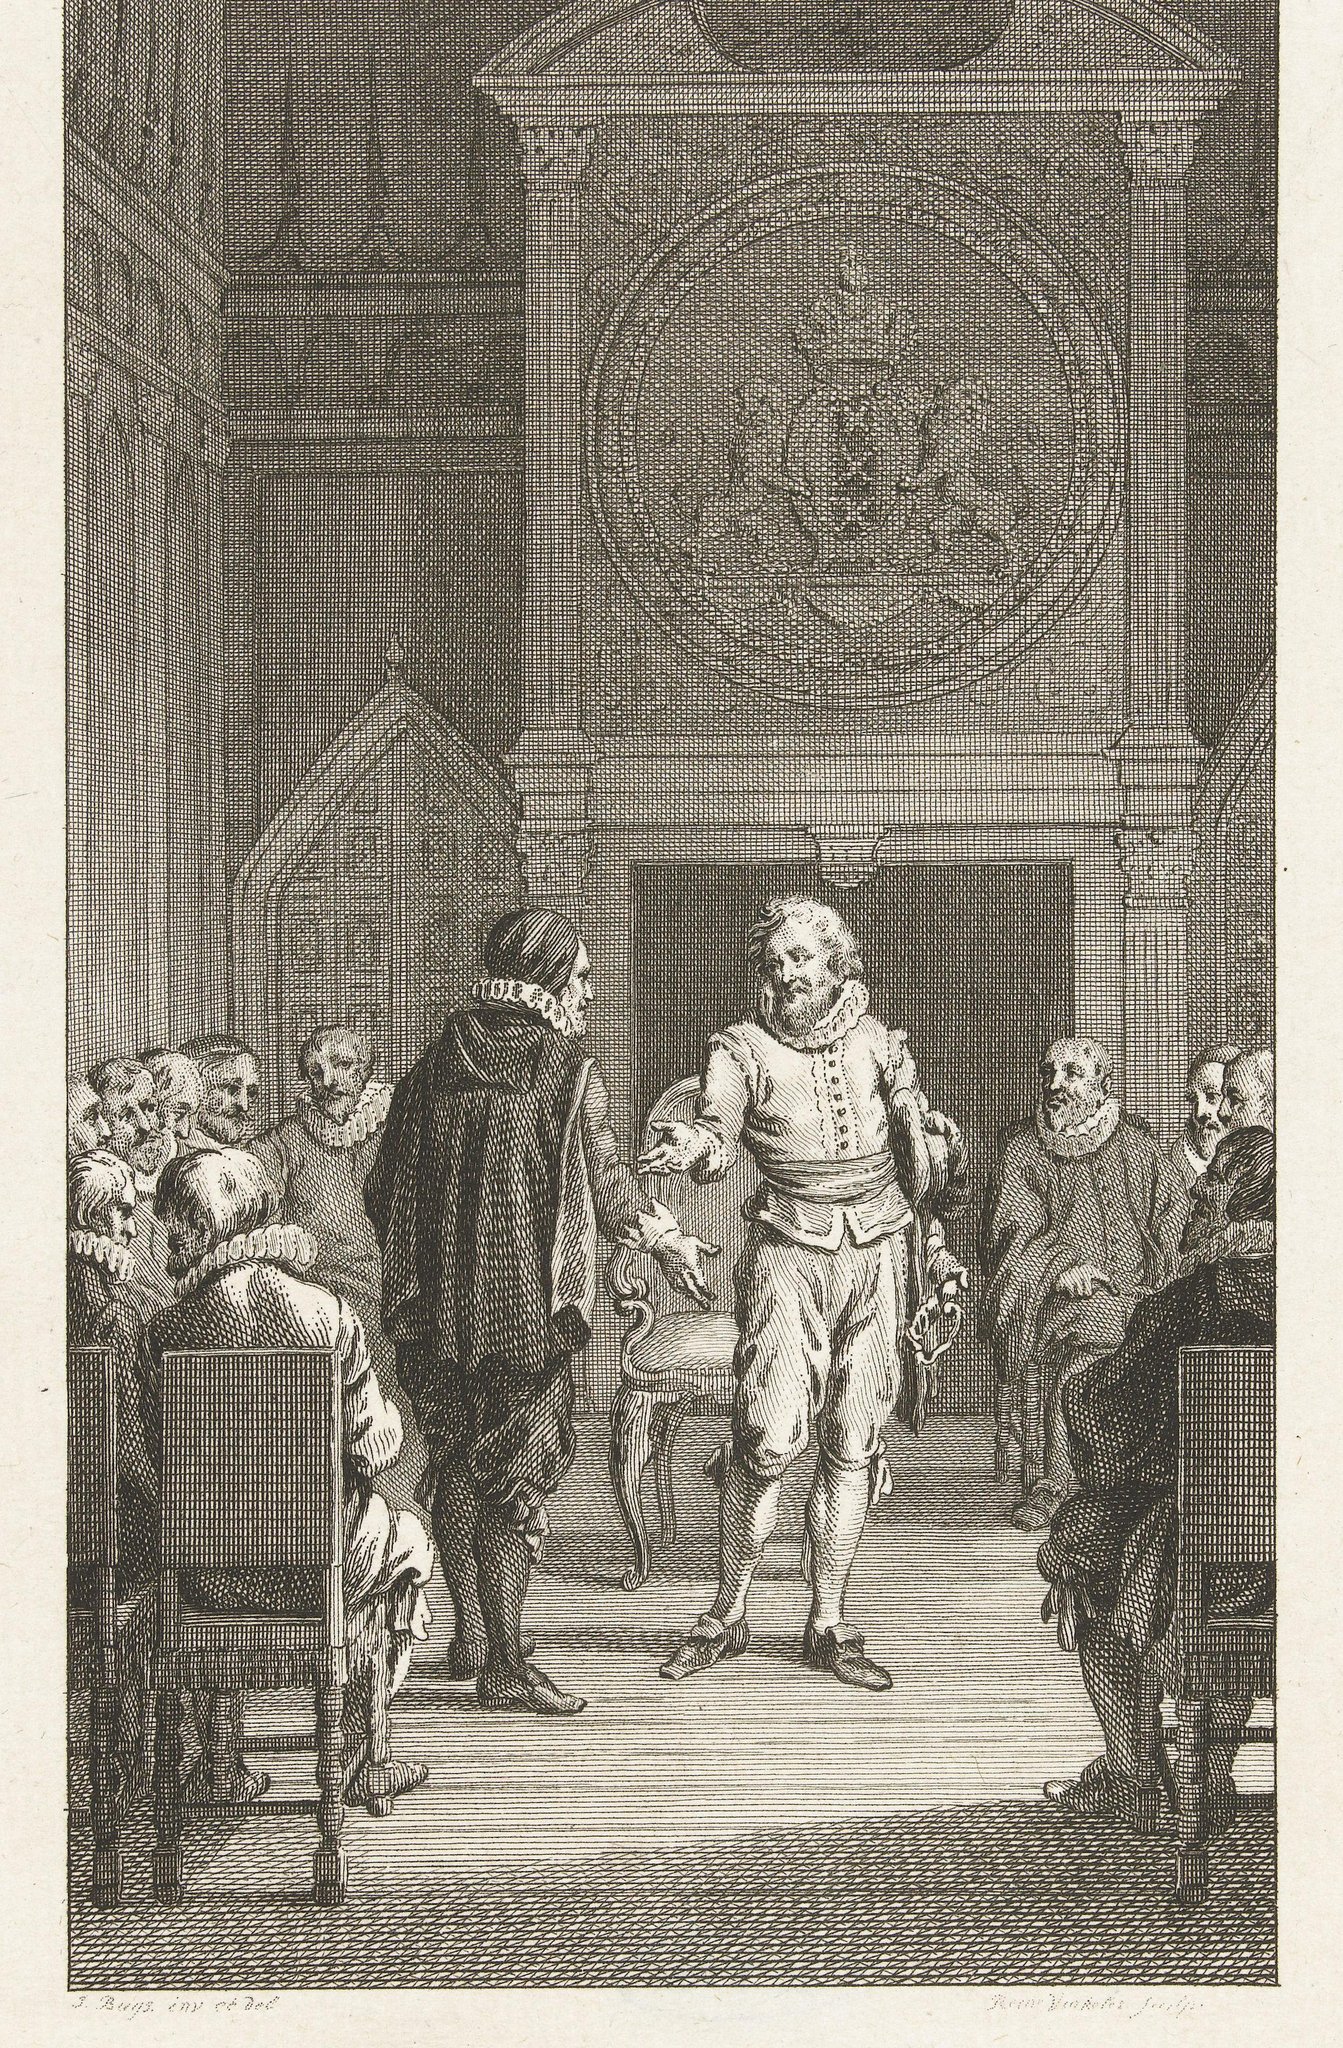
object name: history print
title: Burgemeester Cornelis Pietersz. Hooft pleit bij Maurits tegen het verzetten van de wet te Amsterdam, 1618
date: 1789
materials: paper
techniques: etching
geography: netherlands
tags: the hague, maurice (prince of orange), amsterdam, mayor, cornelis pietersz. hooft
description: Burgemeester Cornelis Pietersz. Hooft pleit bij Maurits tegen het verzetten van de wet te Amsterdam, 3 november 1618. Interieur met Maurits en Hooft staande tegenover elkaar in de raadskamer van het stadhuis te Amsterdam.